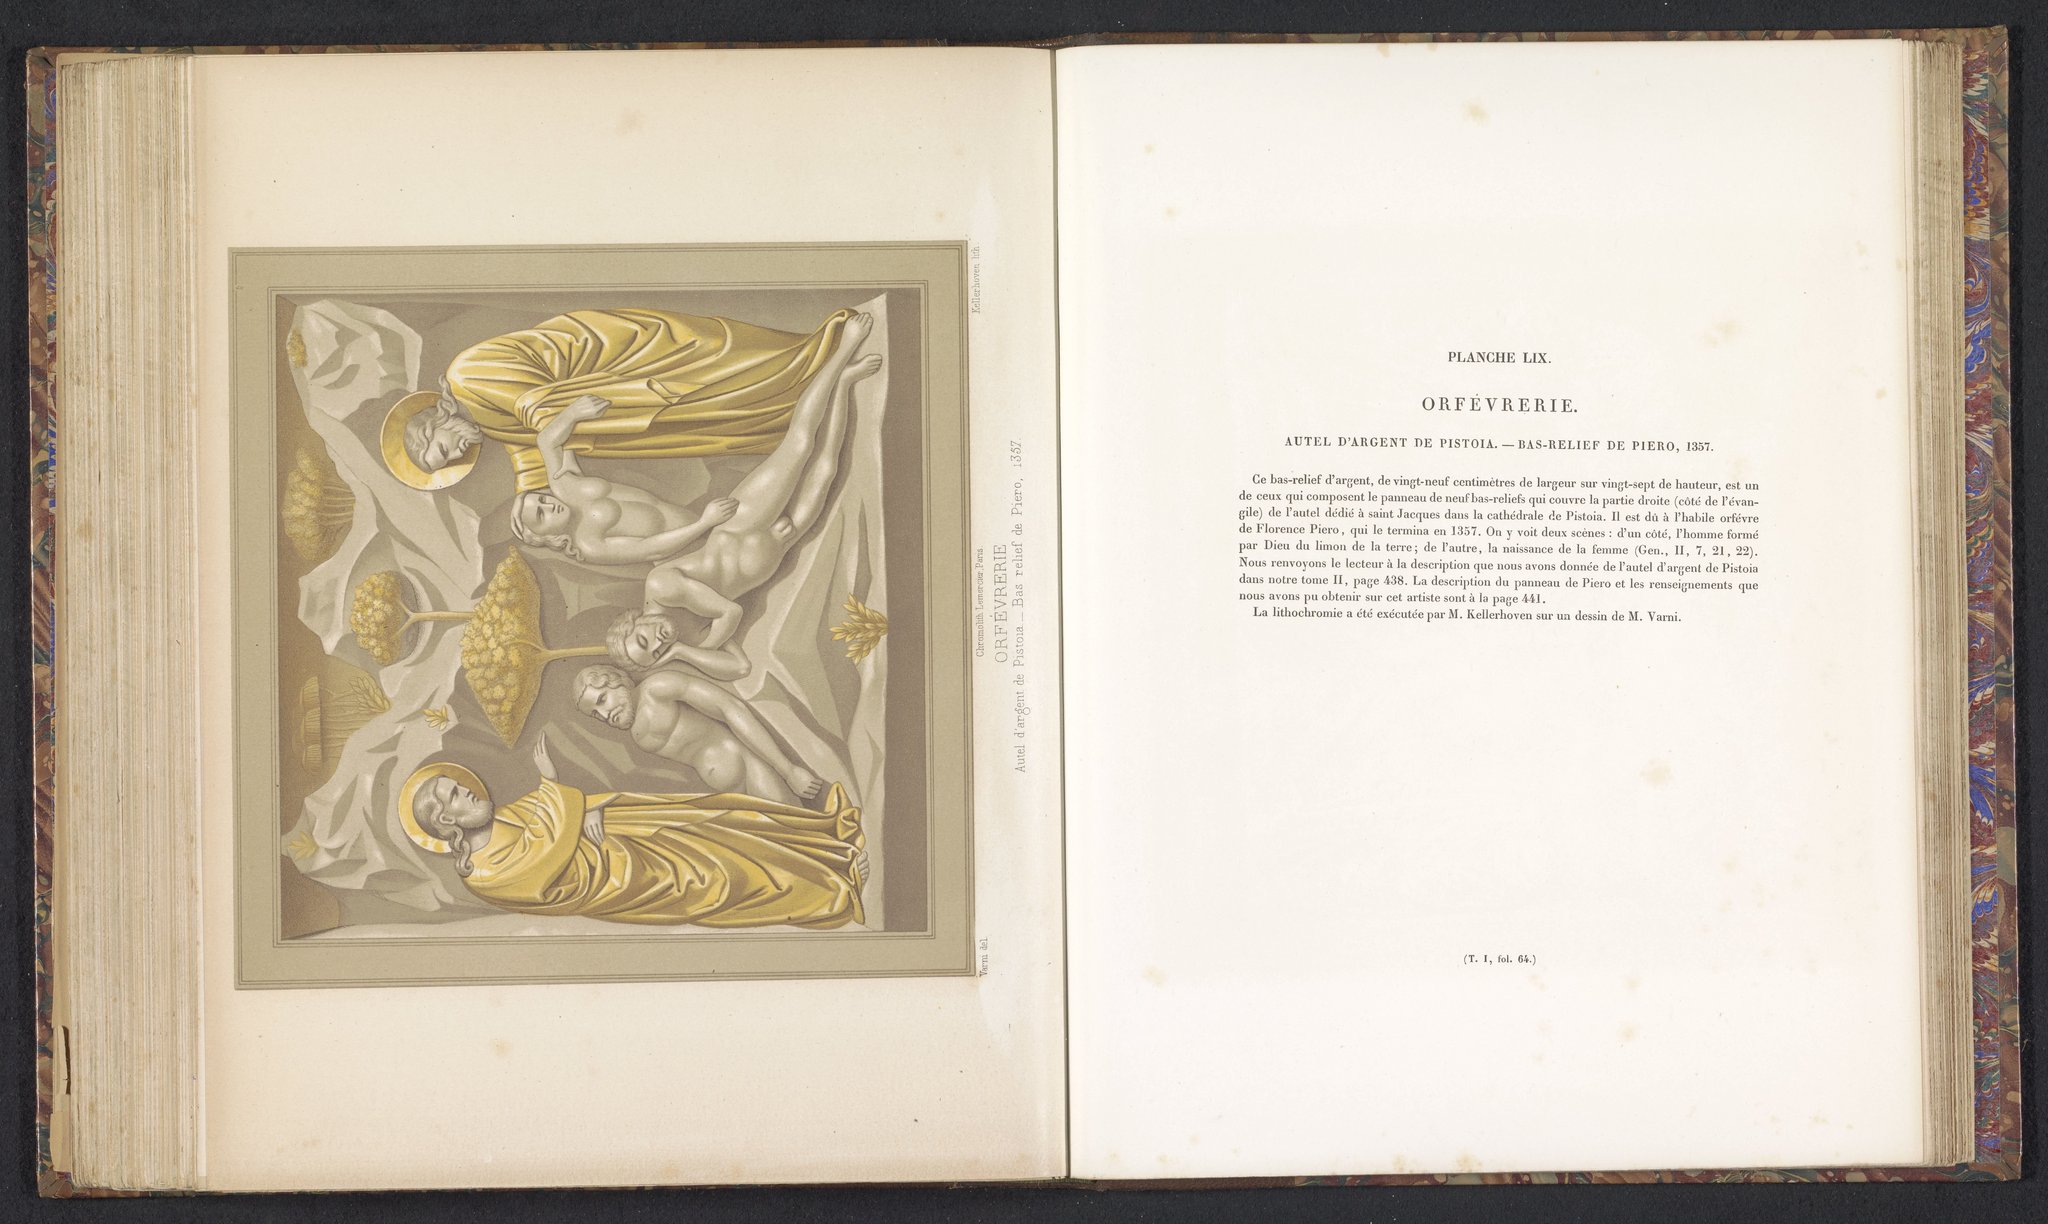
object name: print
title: Orfévrerie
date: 1859-1864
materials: paper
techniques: chromolithography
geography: paris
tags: creation of eve, altar, god fashions man from clay, sculpture (+ relief ~ sculpture)